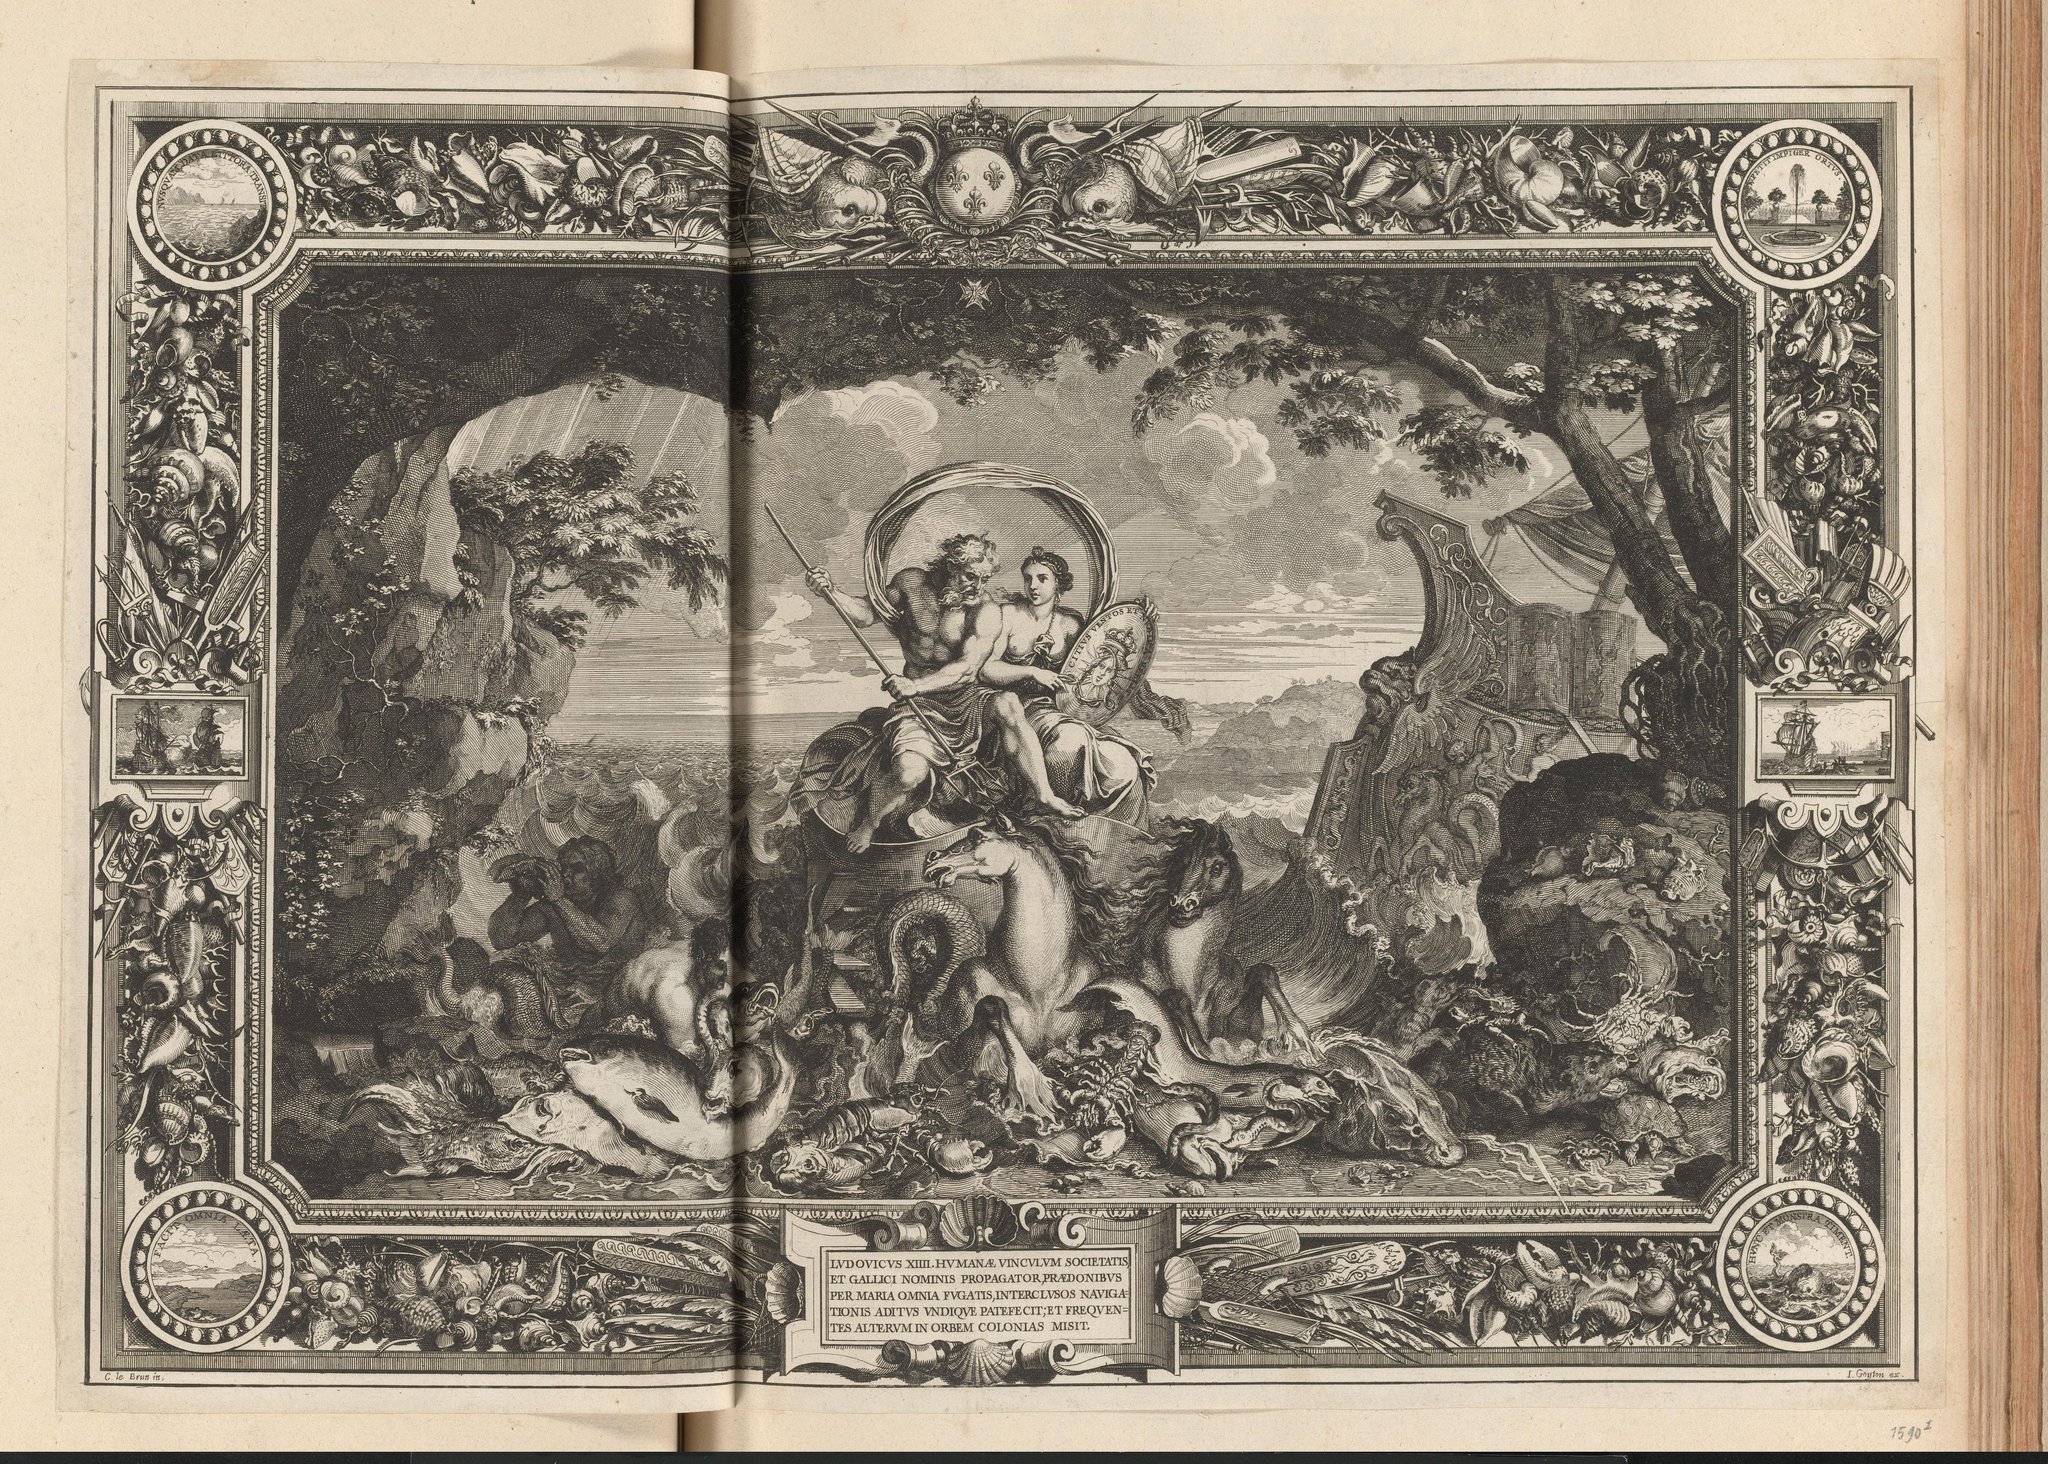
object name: album leaf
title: Allegorie op het element water, in een cartouche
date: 1670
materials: paper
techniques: engraving, etching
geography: paris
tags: (story of) neptune (poseidon), water (one of the four elements), (story of) thetis; 'thethi, ninfa del mare' (ripa), fishes, scallop, shell ~ ornament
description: Prent gebruikt voor: Félibien, André. Devises pour les tapisseries du Roy, où sont représentez les quatre éléments et les quatre saisons de l'année (...). Parijs: Imprimerie Royale, 1670.